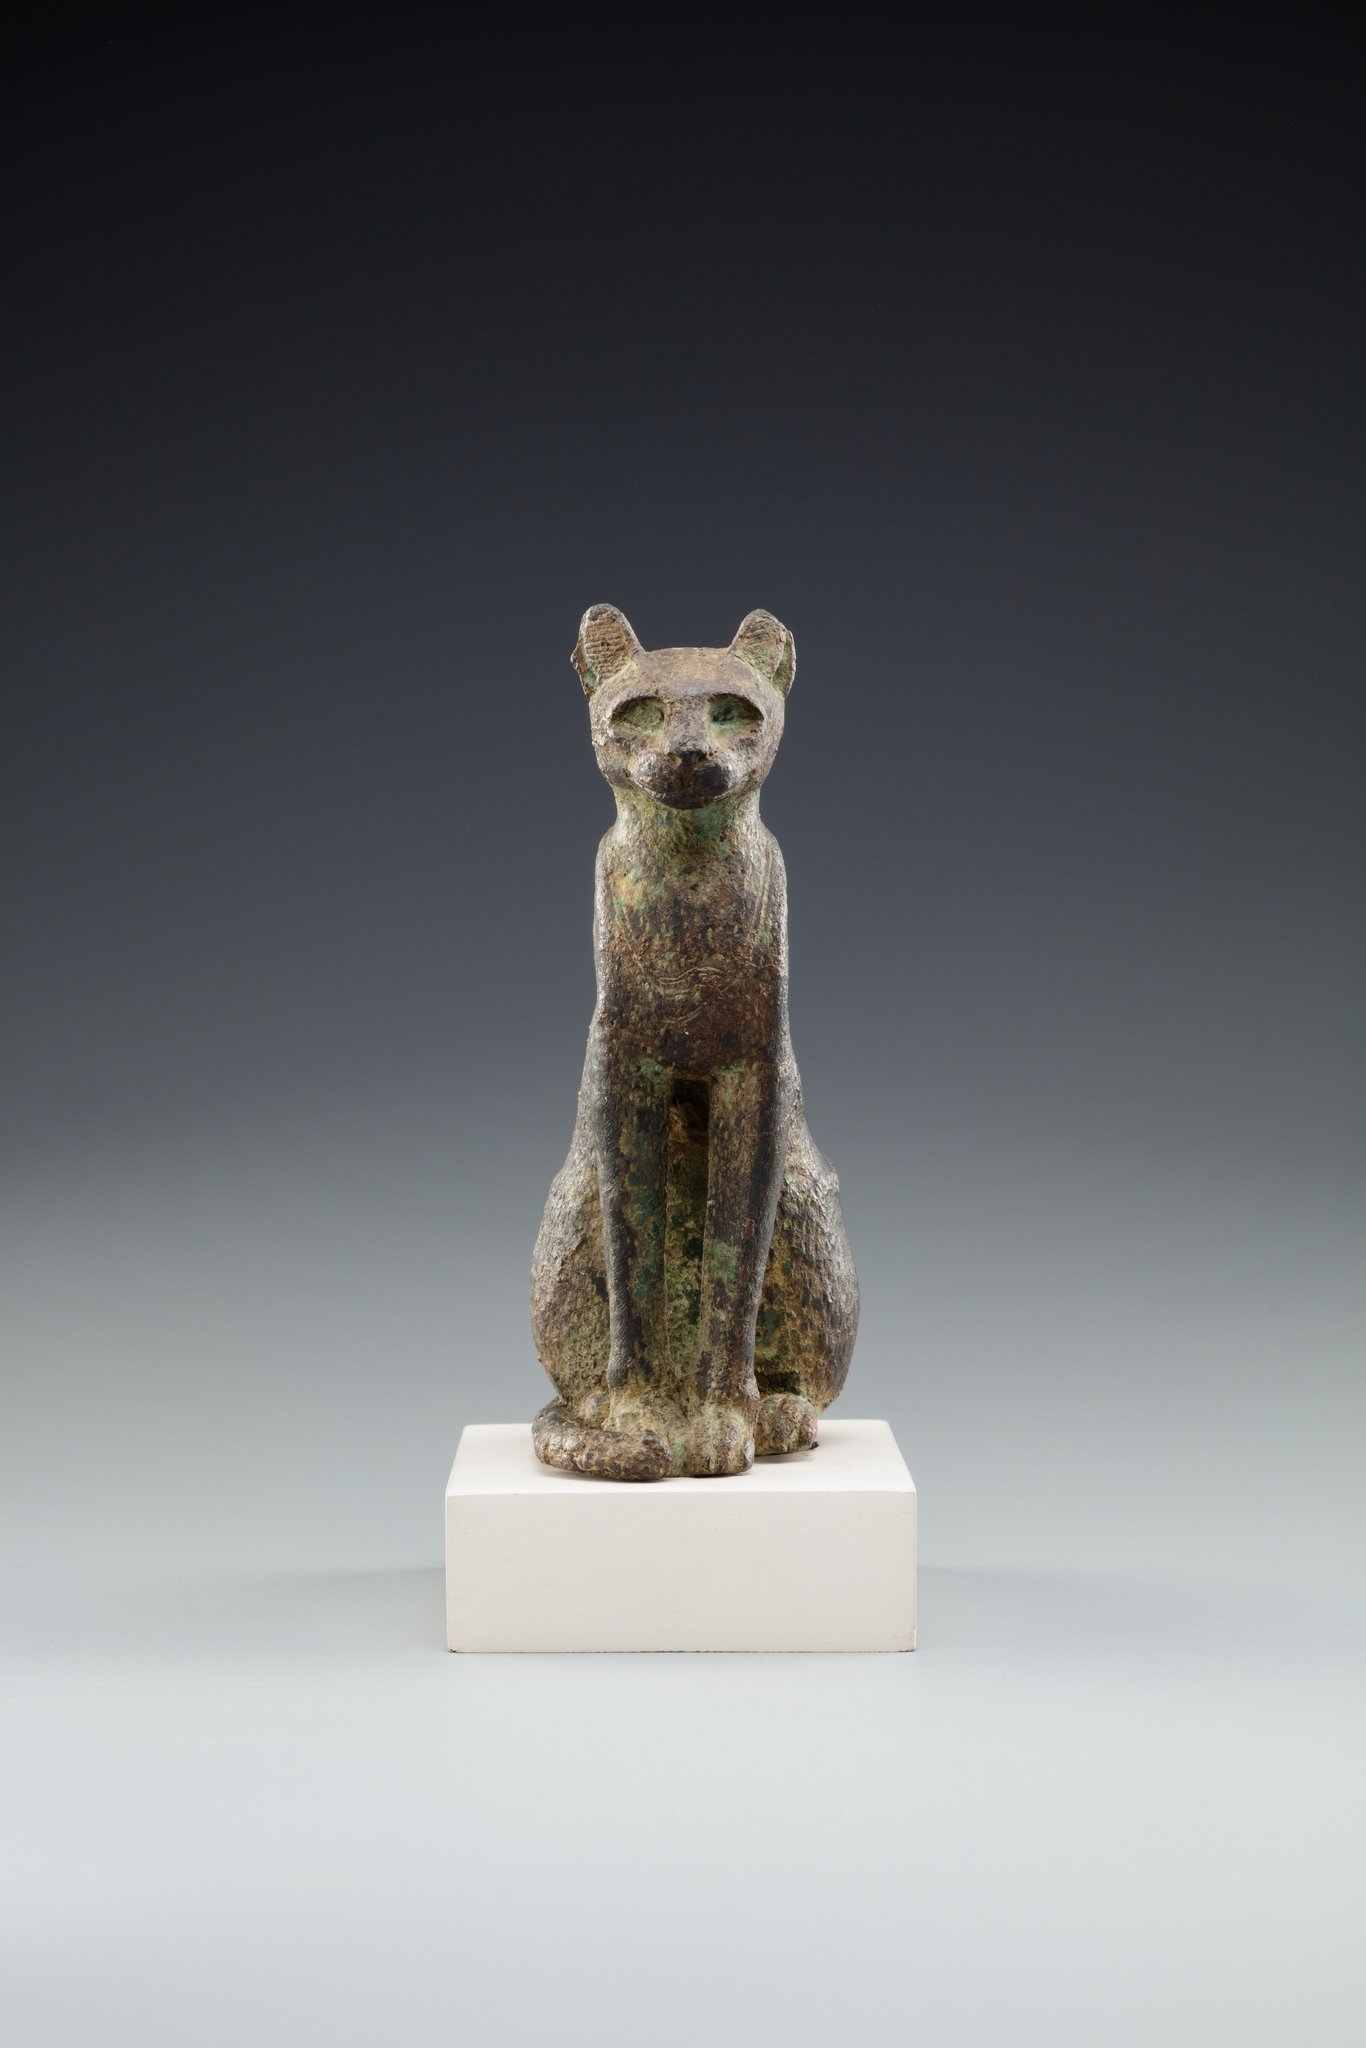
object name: figurine, cat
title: Cat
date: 664-630 BCE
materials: metal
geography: egypt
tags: cats